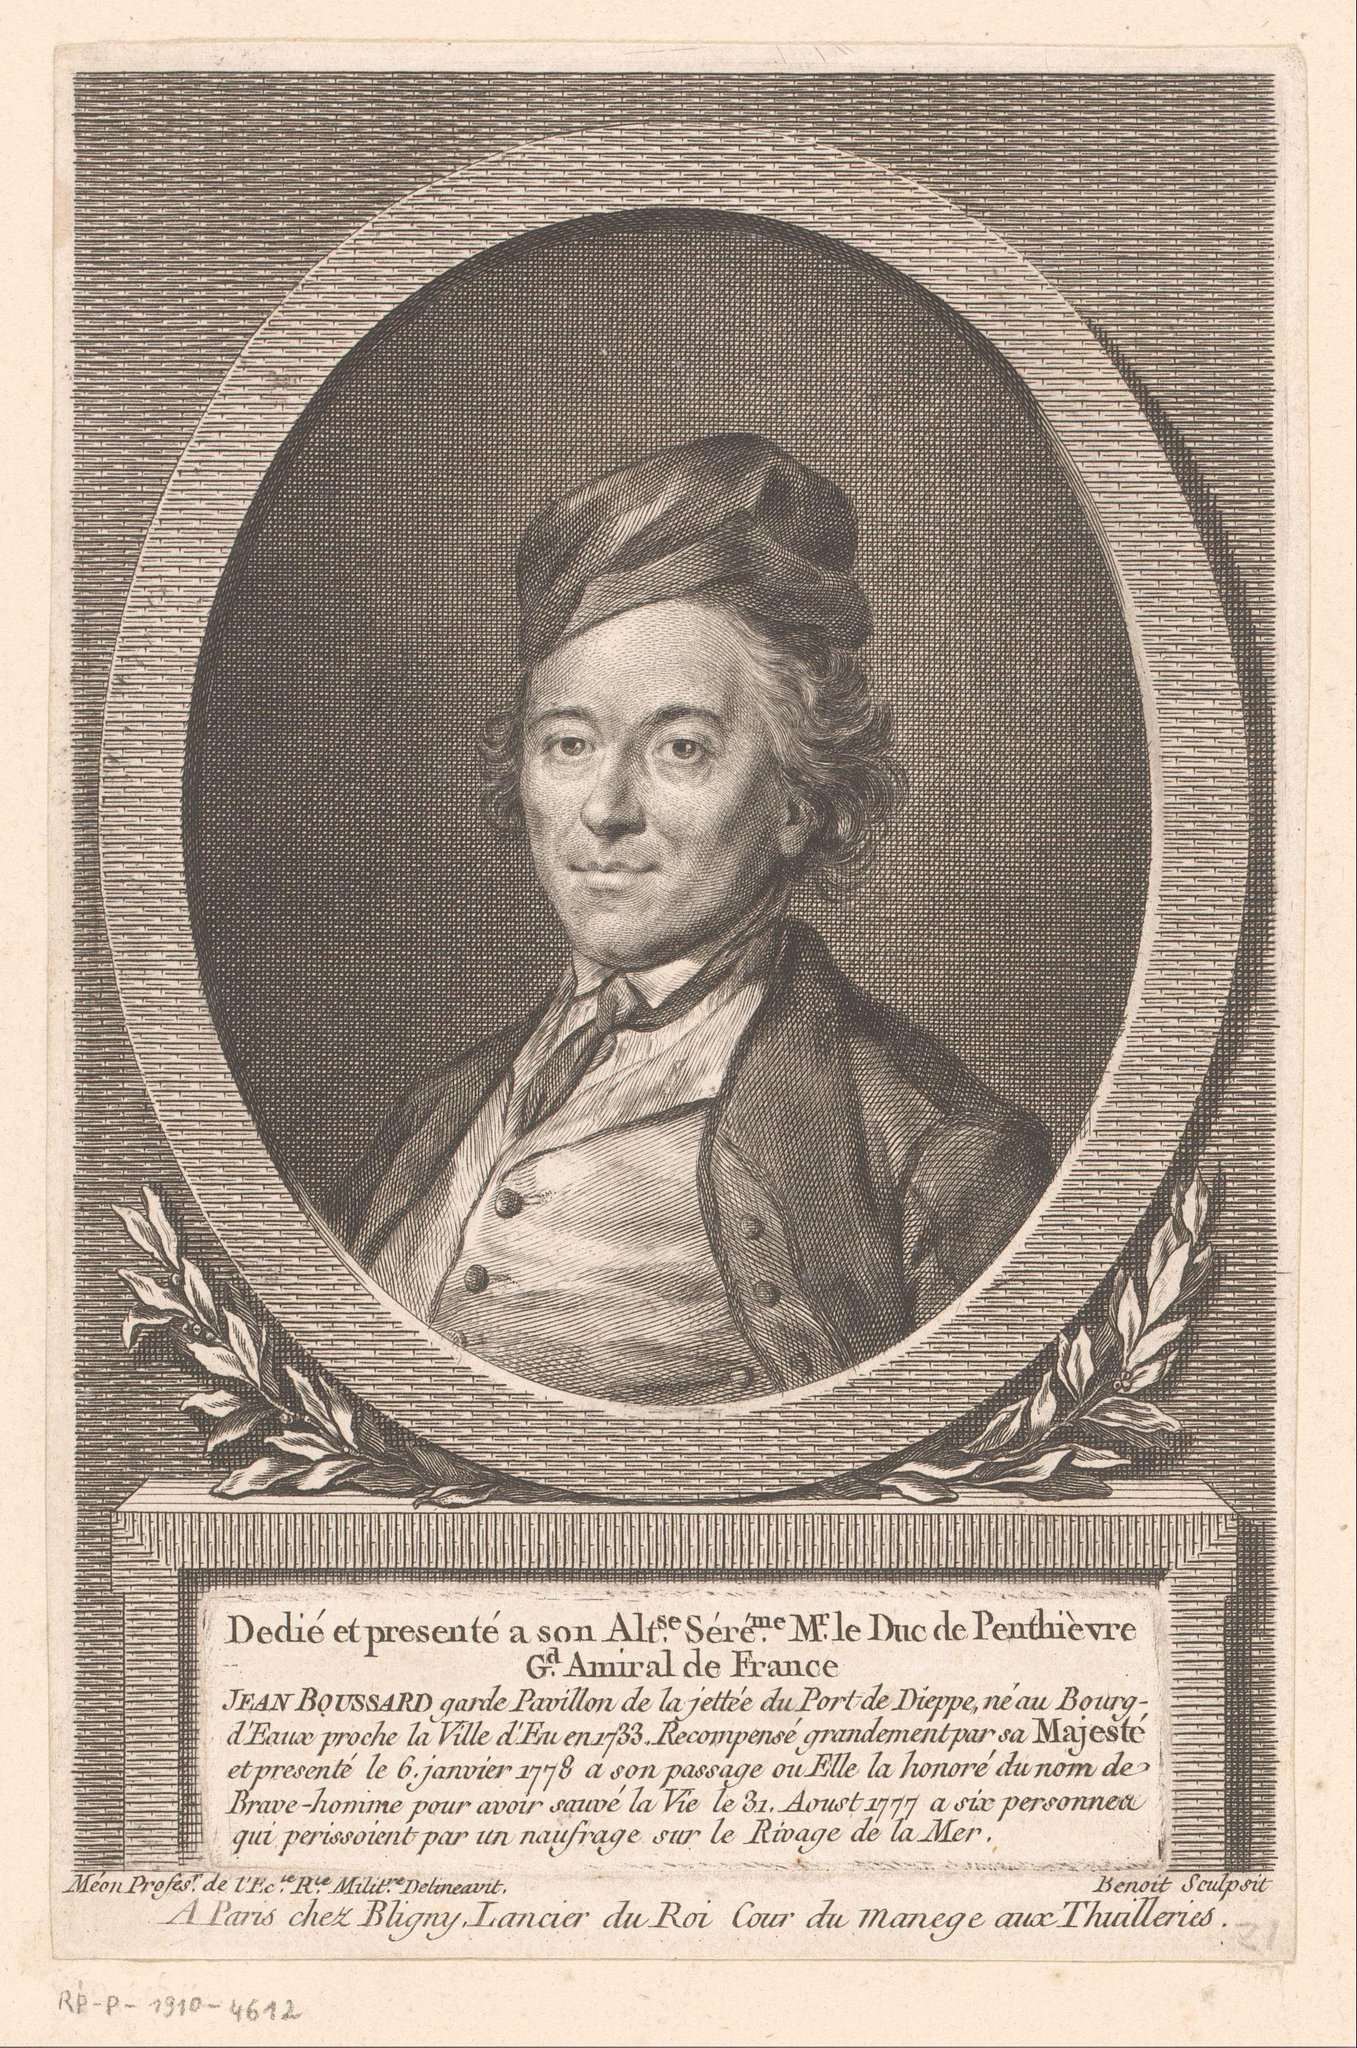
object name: print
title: Portret van Jean Boussard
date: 1760-1785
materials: paper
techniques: engraving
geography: paris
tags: ornament ~ medallion, historical persons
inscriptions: collector's mark: Lugt 2228